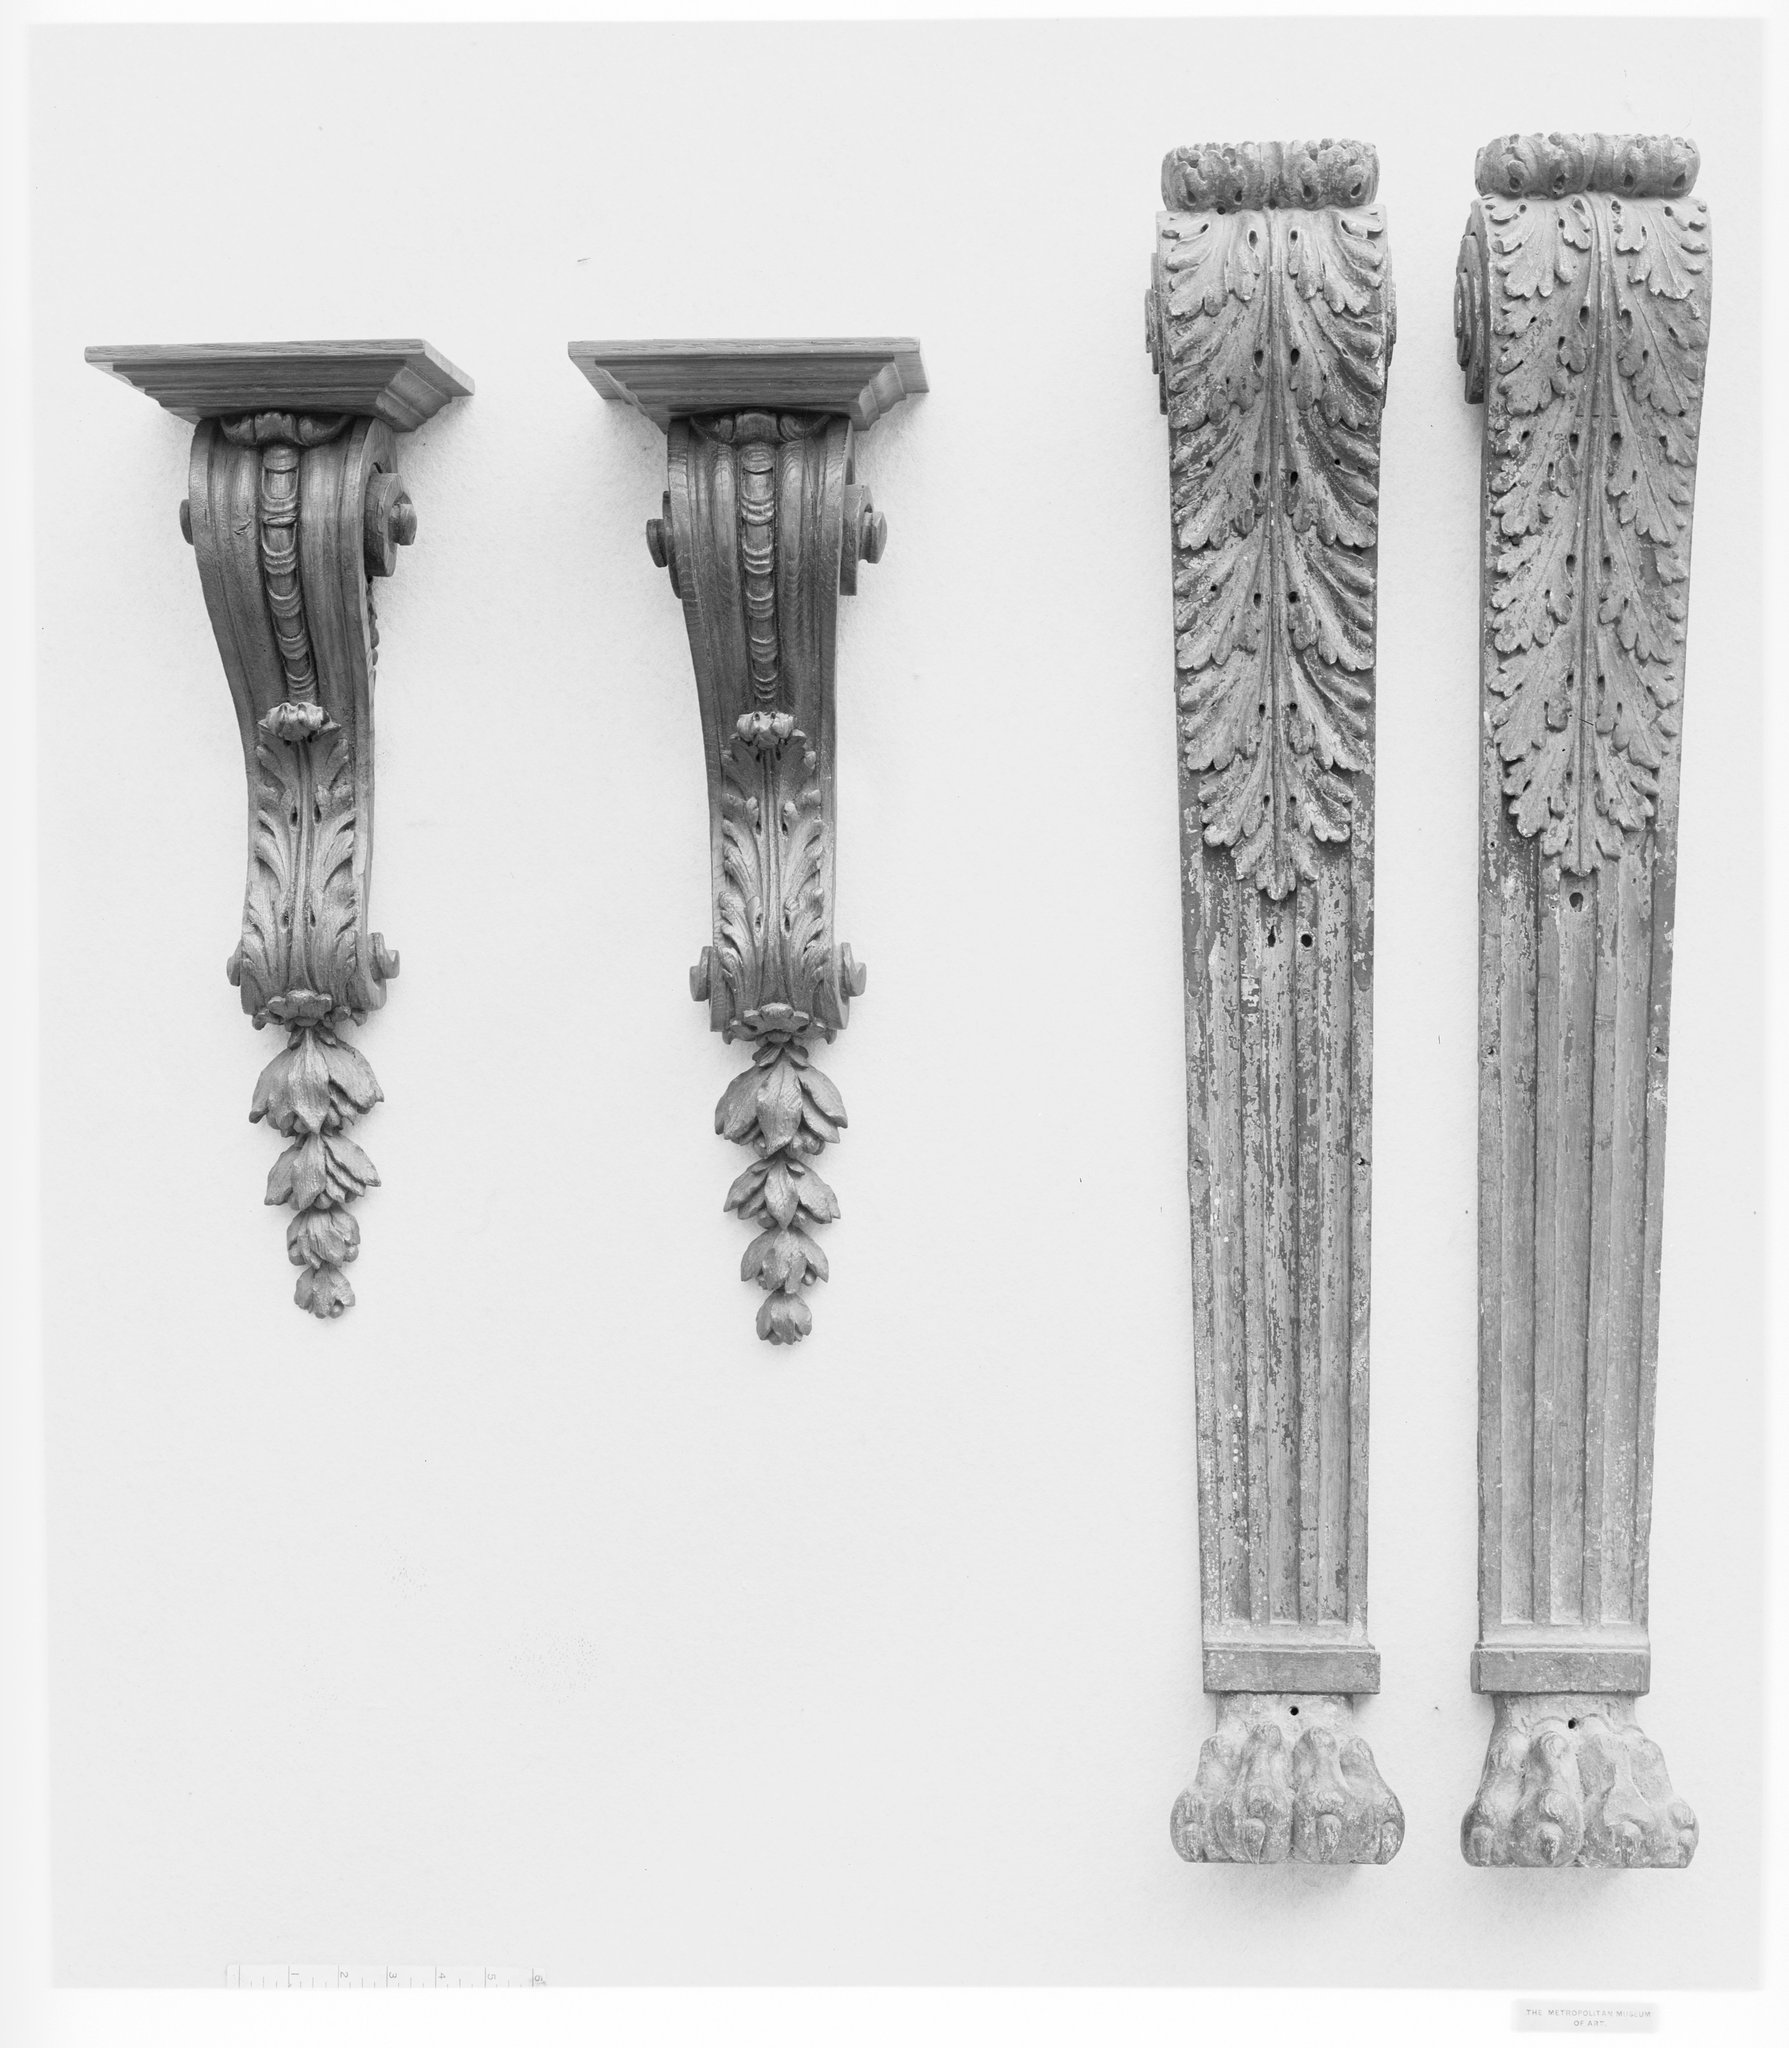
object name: console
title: Pair of consoles (consoles d'appliques)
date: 1701-1800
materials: wood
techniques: carving, gilding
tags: leaves